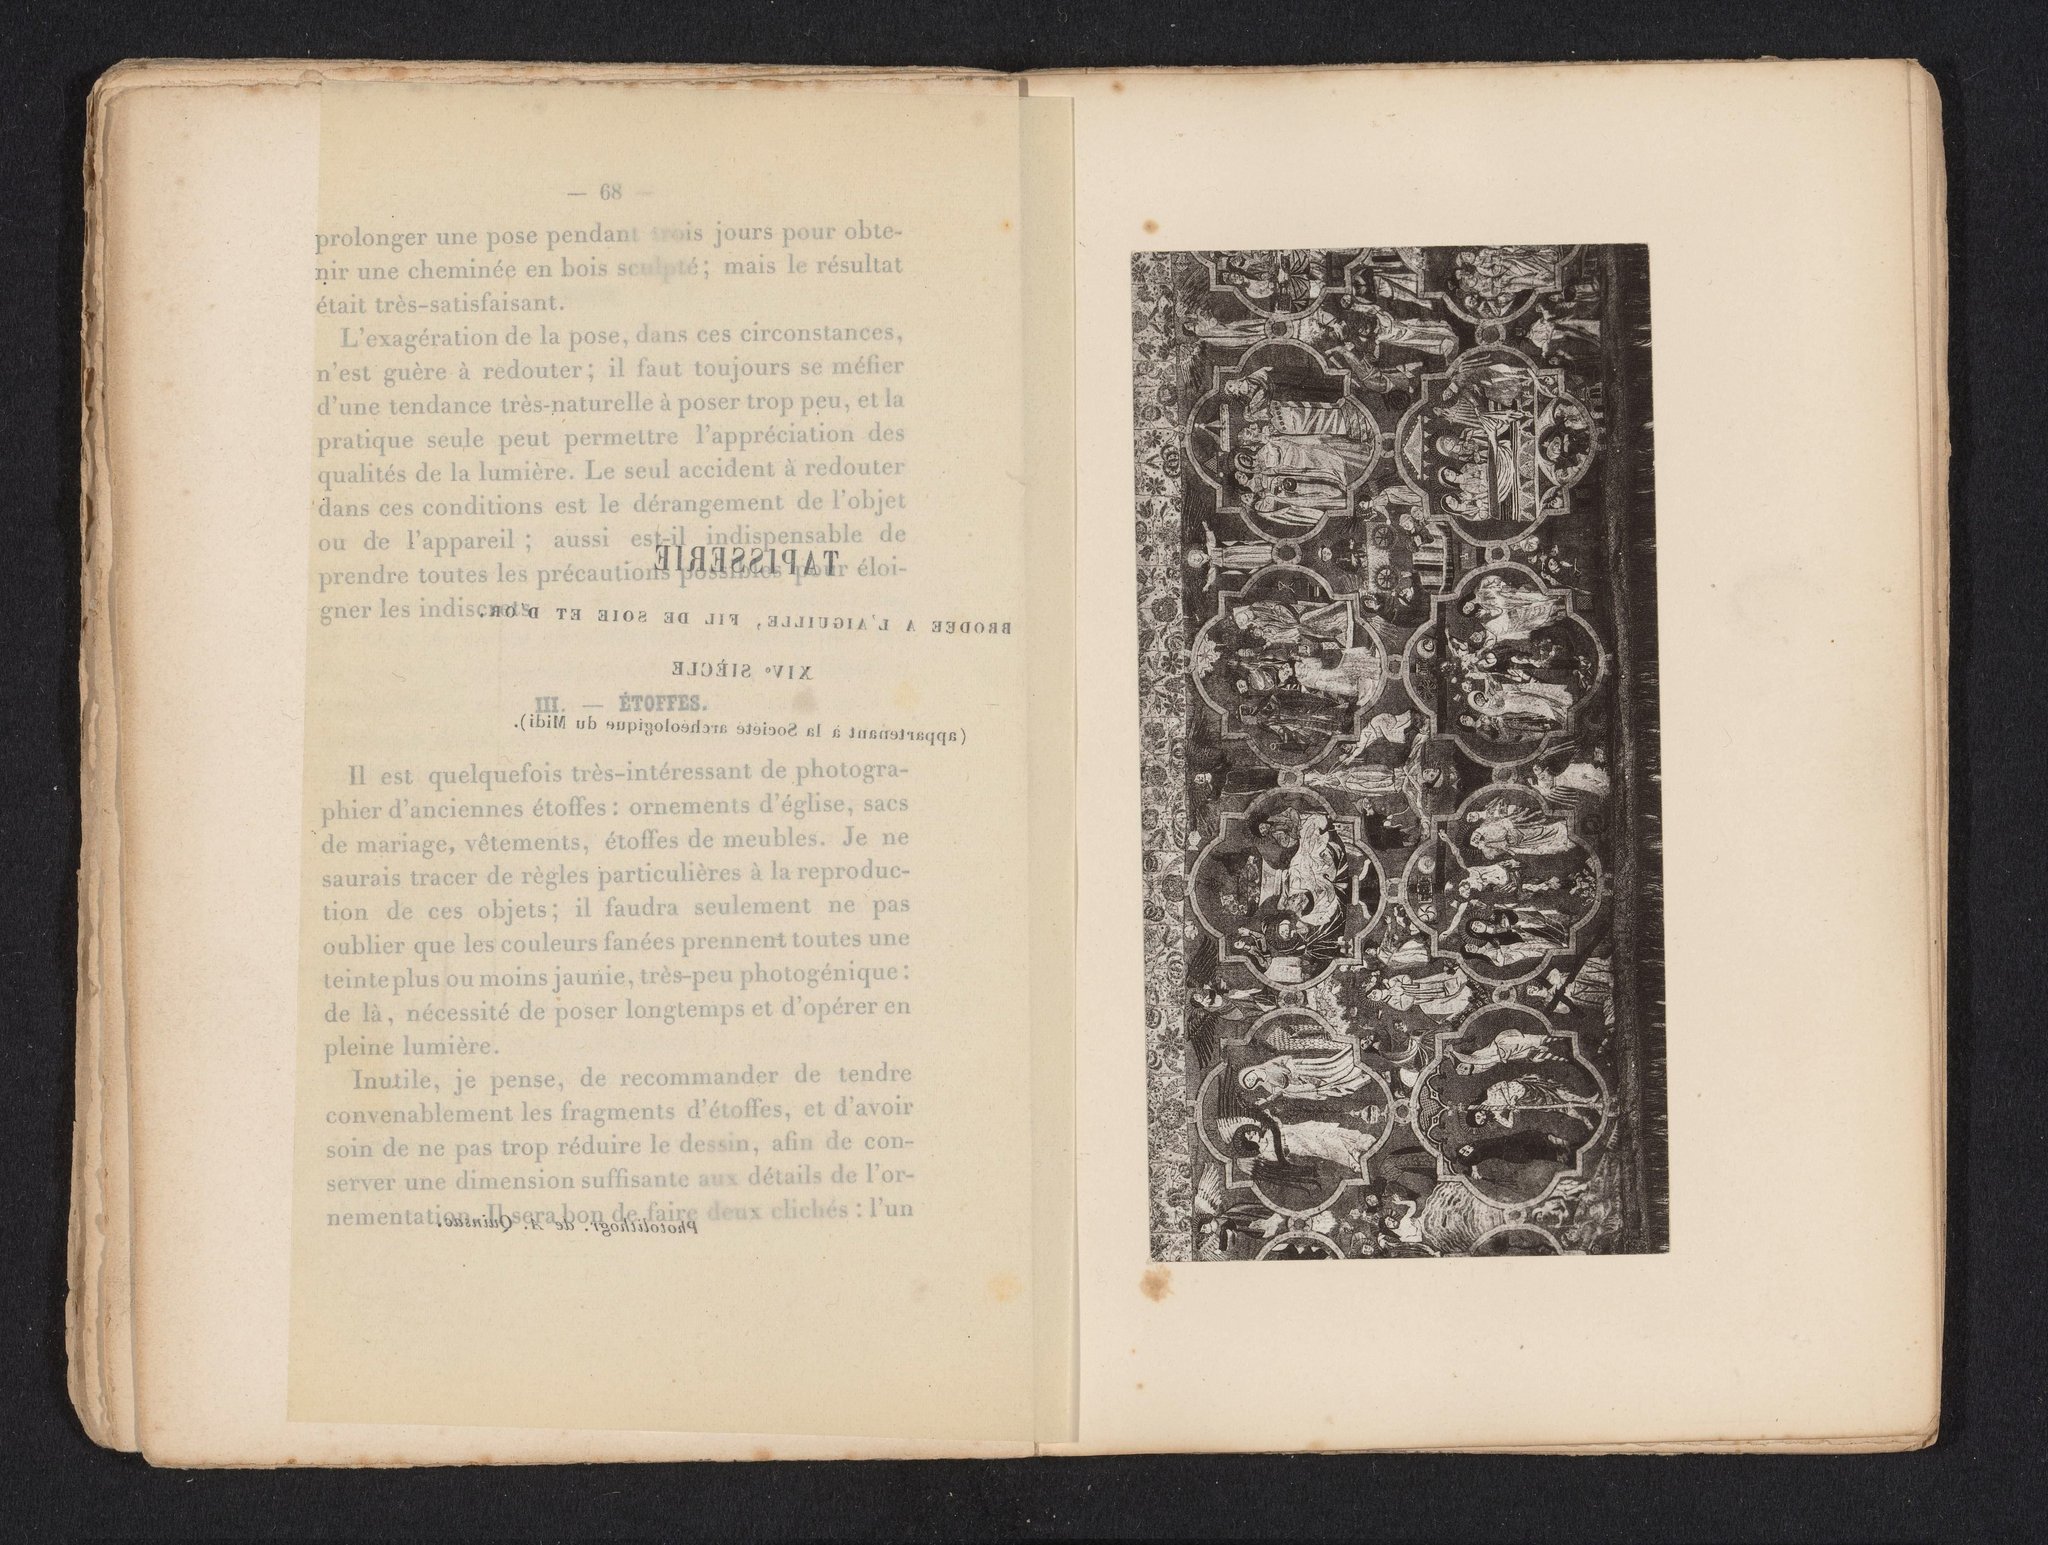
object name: photomechanical print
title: Tapijt met Bijbelse voorstellingen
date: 1869-1879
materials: paper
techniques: photograph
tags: tapestry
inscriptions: inscription: ‘(appartenant à la Societe archeologique du Midi).’